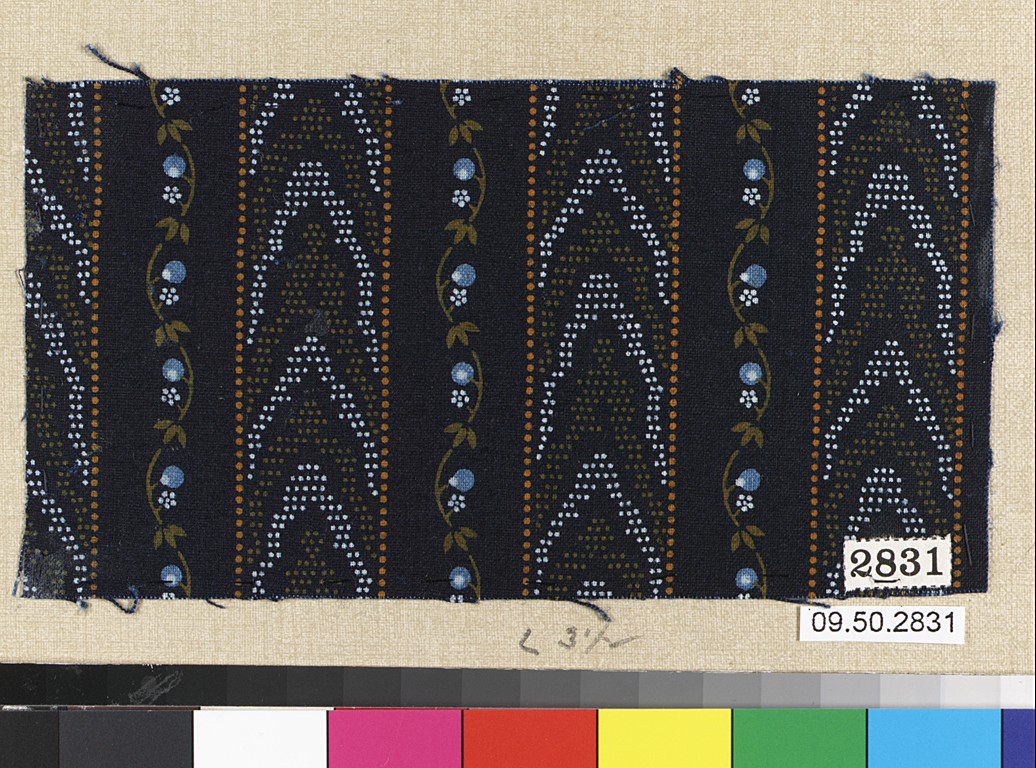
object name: piece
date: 1801-1900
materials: cotton